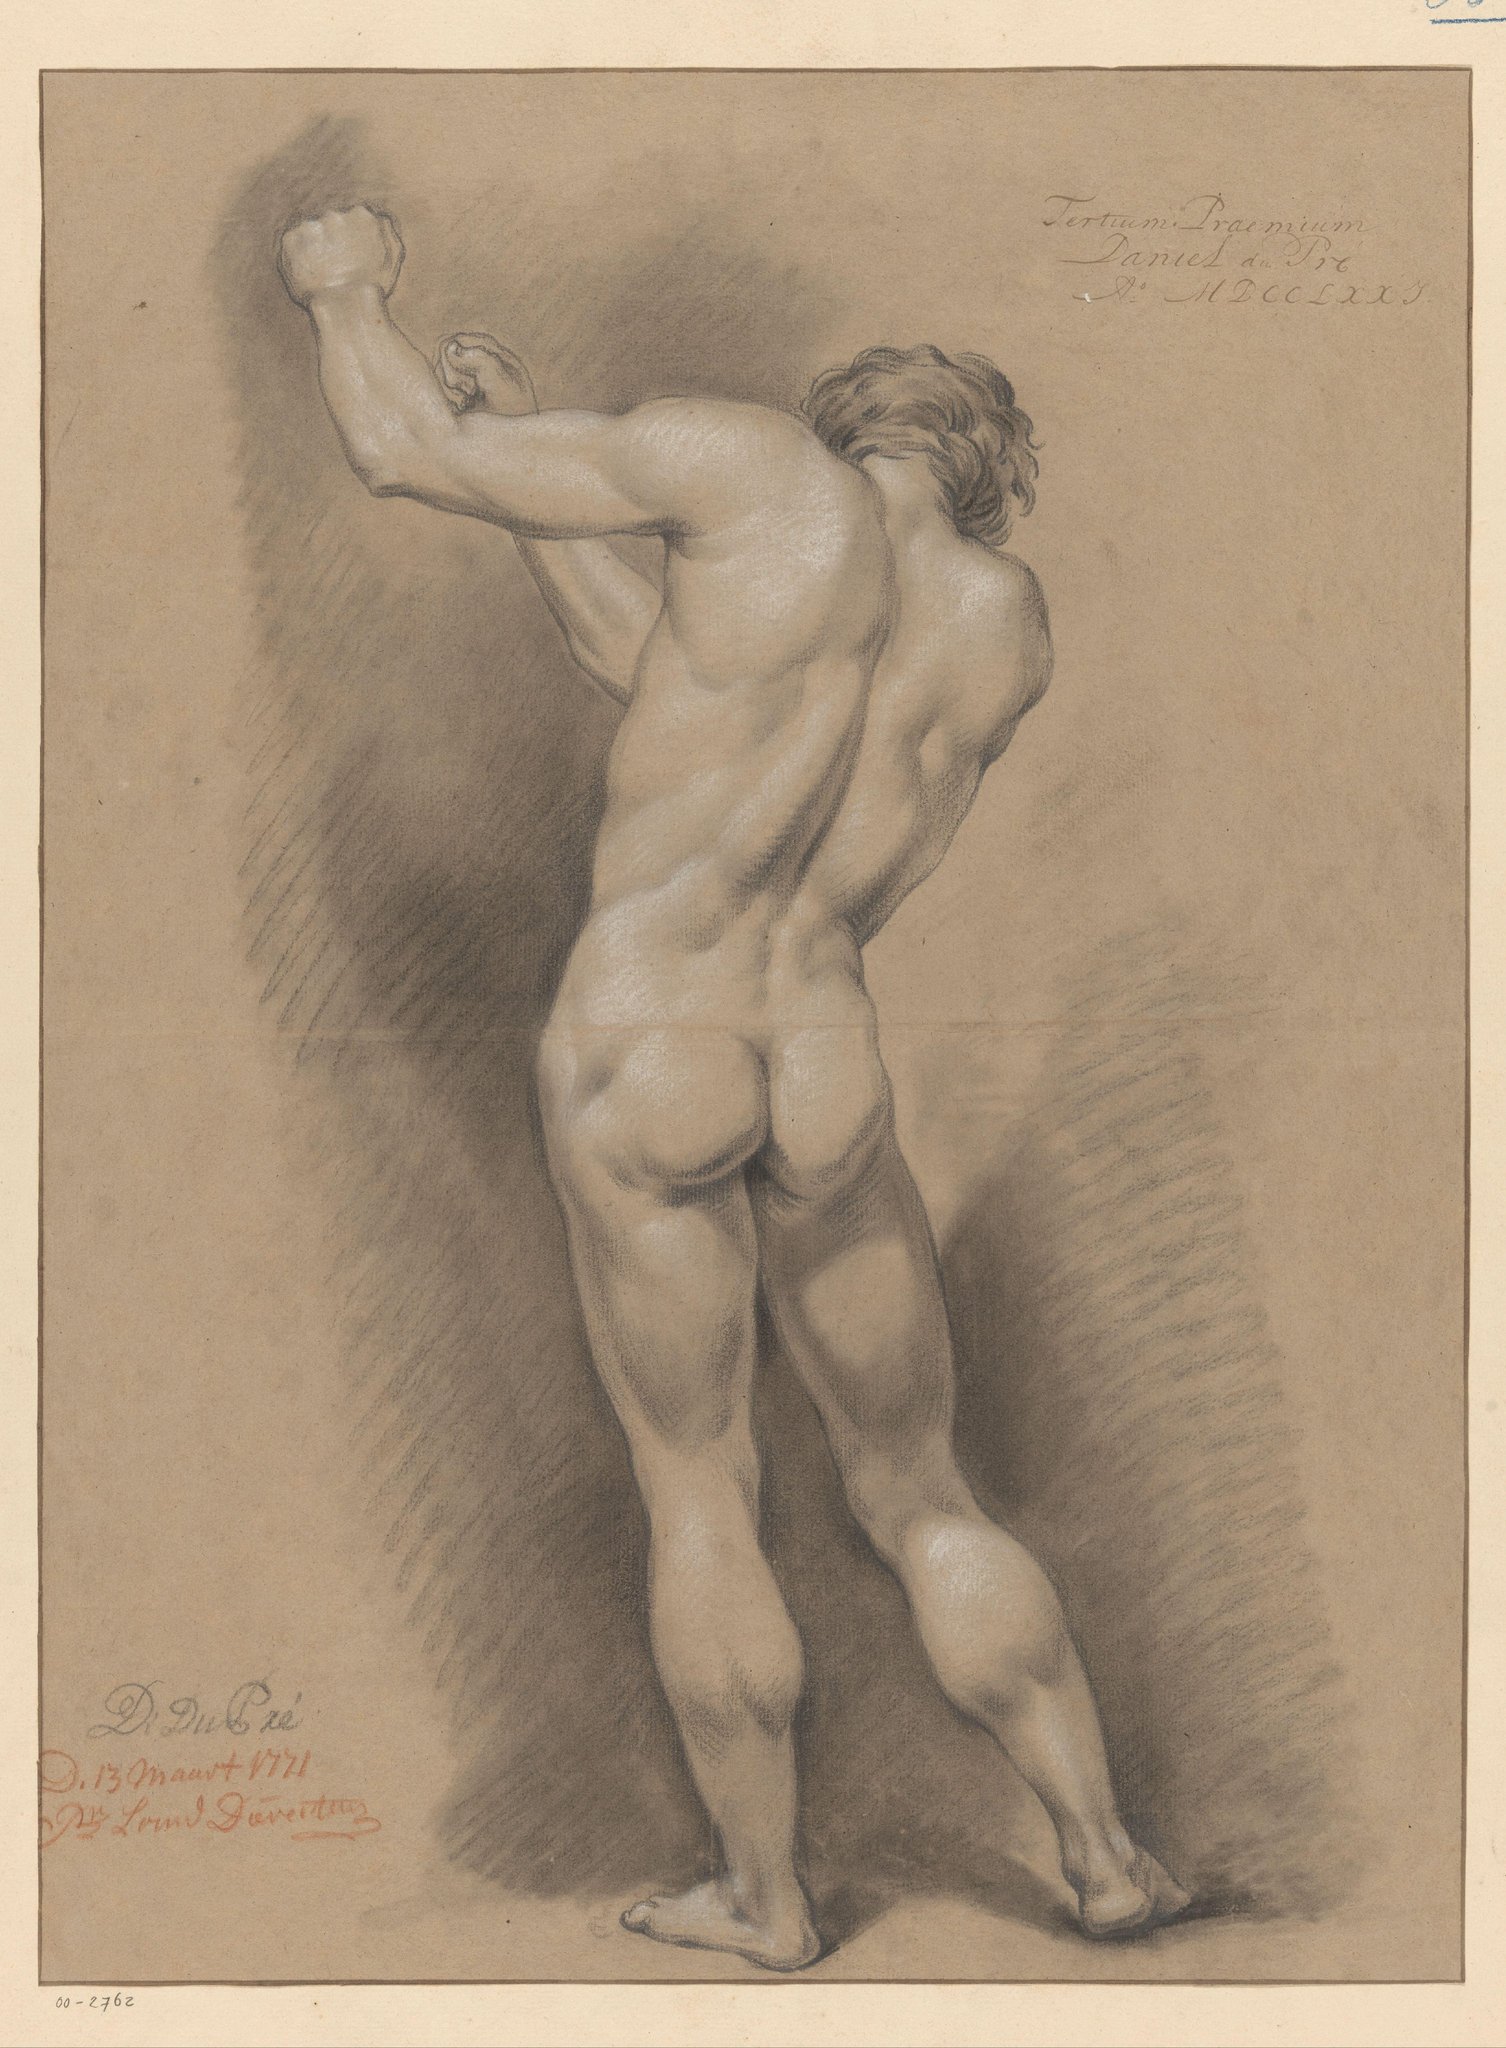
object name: drawing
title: Staand mannelijk naakt, op de rug gezien (3e prijs 1771)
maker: daniël dupré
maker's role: draughtsman, print maker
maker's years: 1751-1817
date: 1771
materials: chalk, paper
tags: standing figure (+ nude human being)